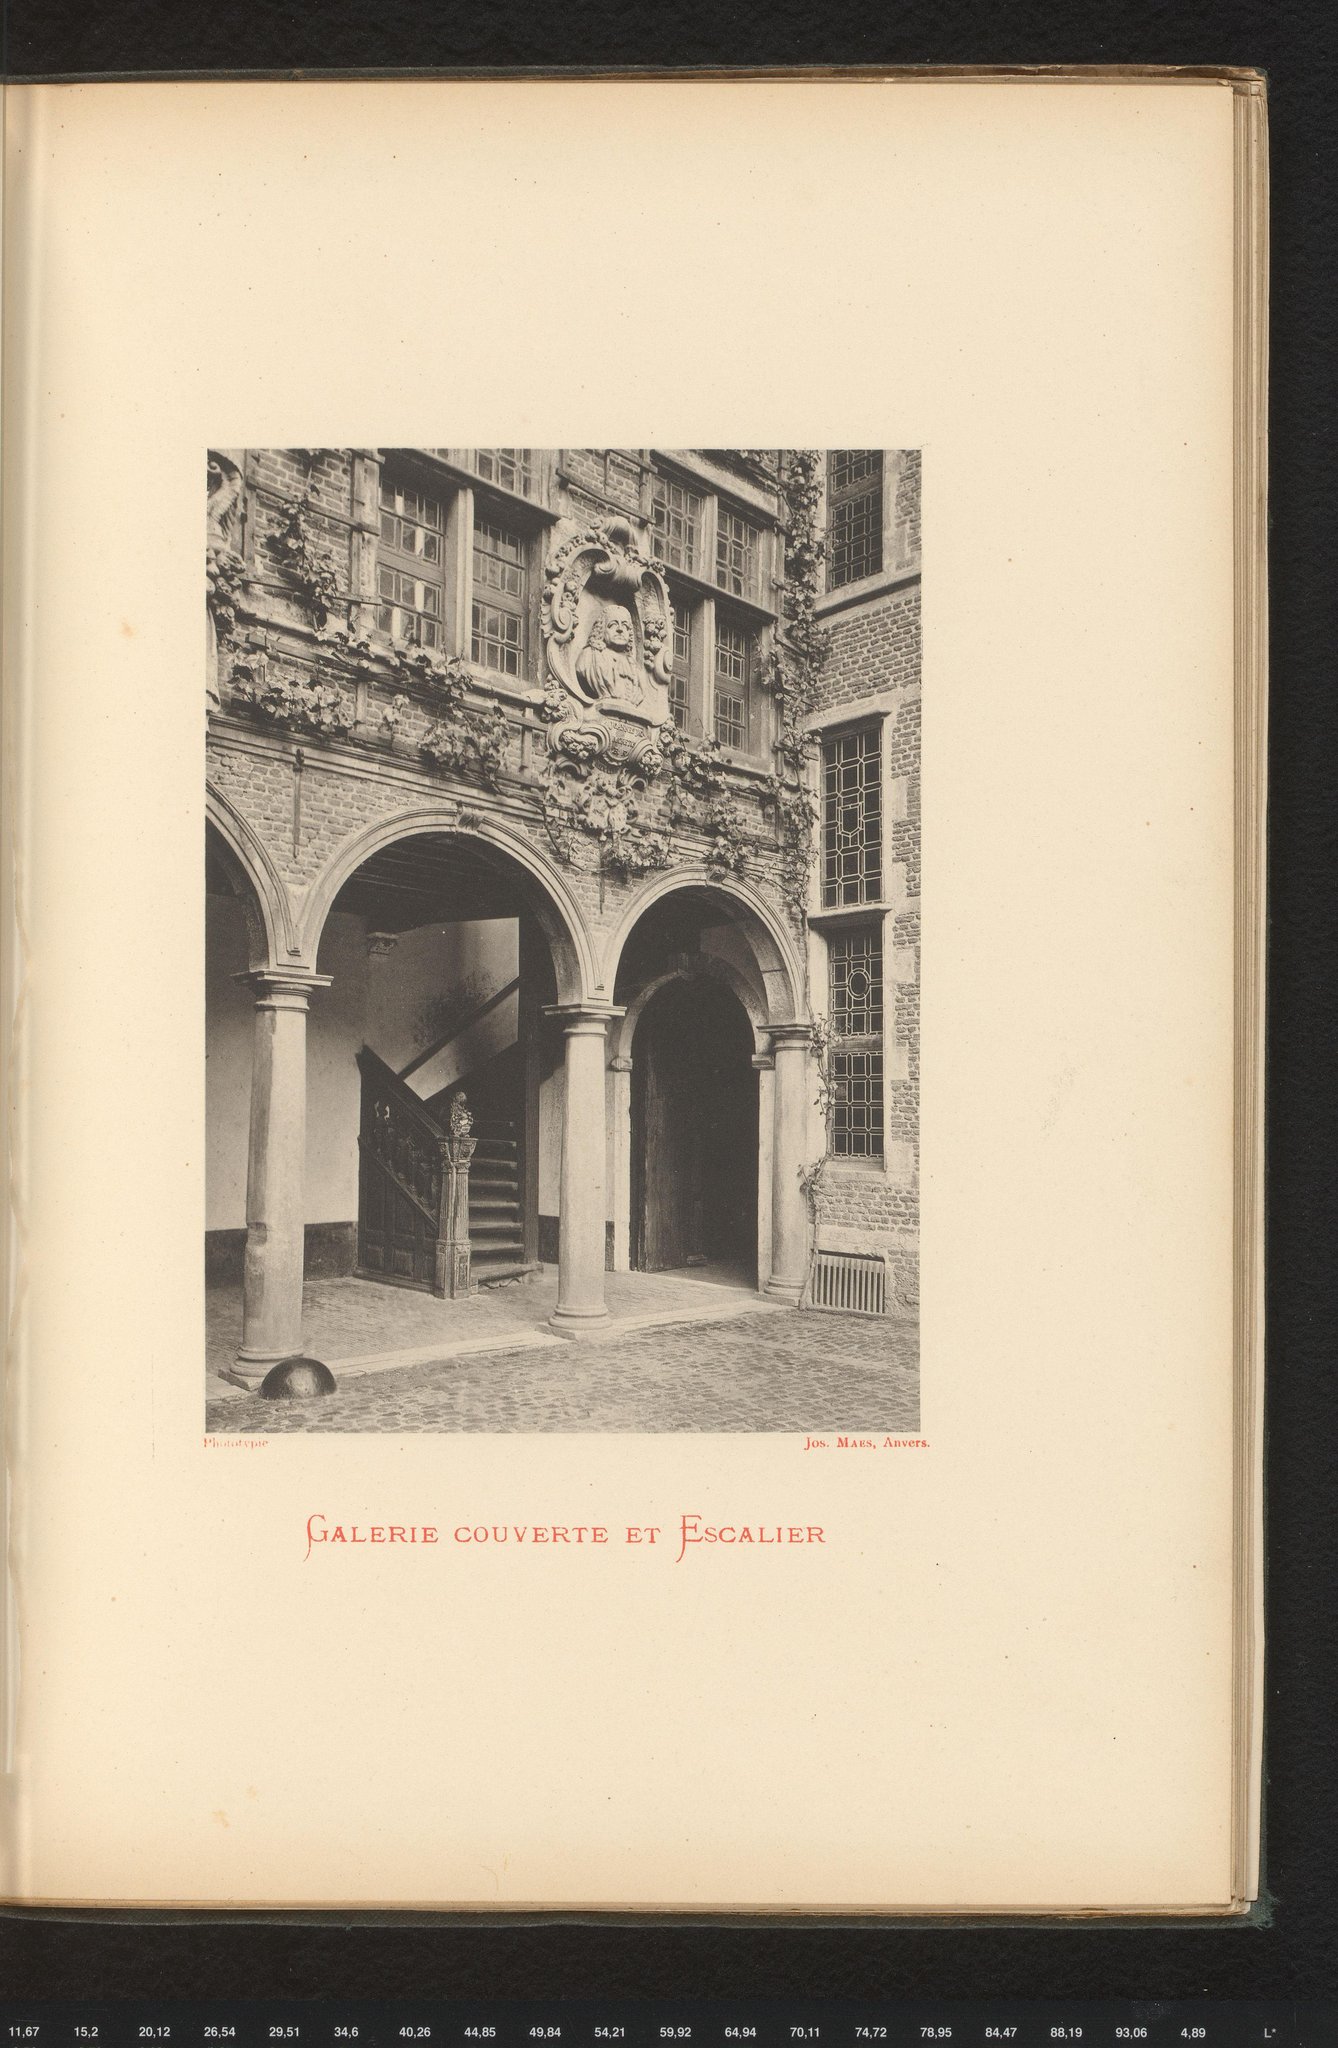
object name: photomechanical print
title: Overdekte gang met trap van het huis van Christoffel Plantijn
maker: joseph maes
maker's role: fotograaf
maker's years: 1838-1908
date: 1877-1882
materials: paper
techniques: photograph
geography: antwerp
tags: corridor, staircase